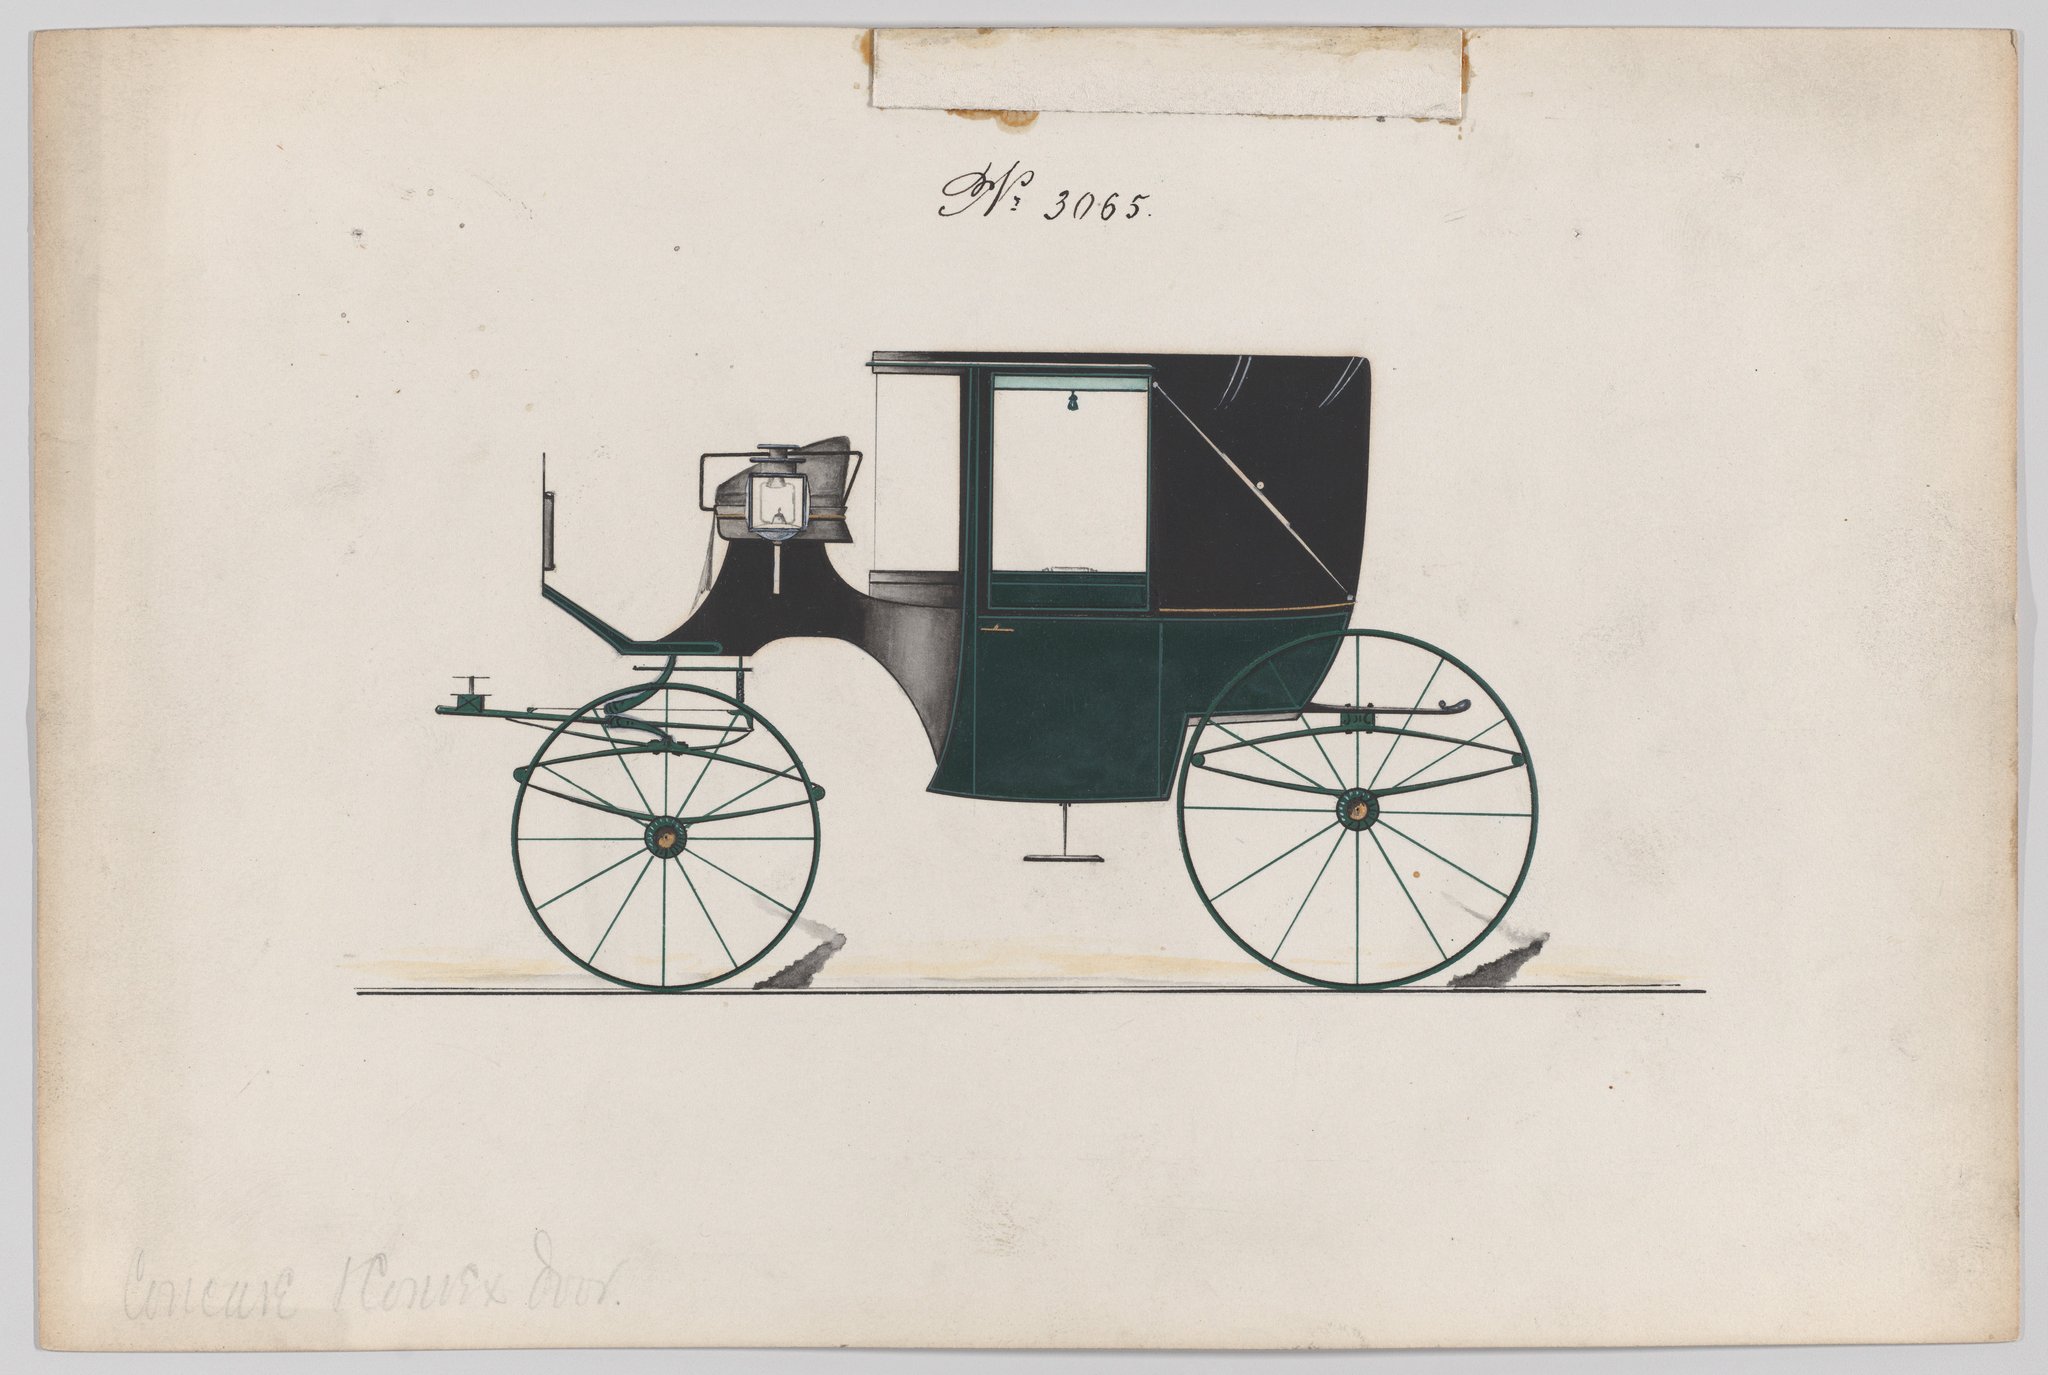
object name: drawing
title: Design for Landaulet, no. 3065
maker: brewster & co.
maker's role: manufacturer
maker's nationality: american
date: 1874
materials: gouache, gum arabic, ink, watercolor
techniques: pen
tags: carriages